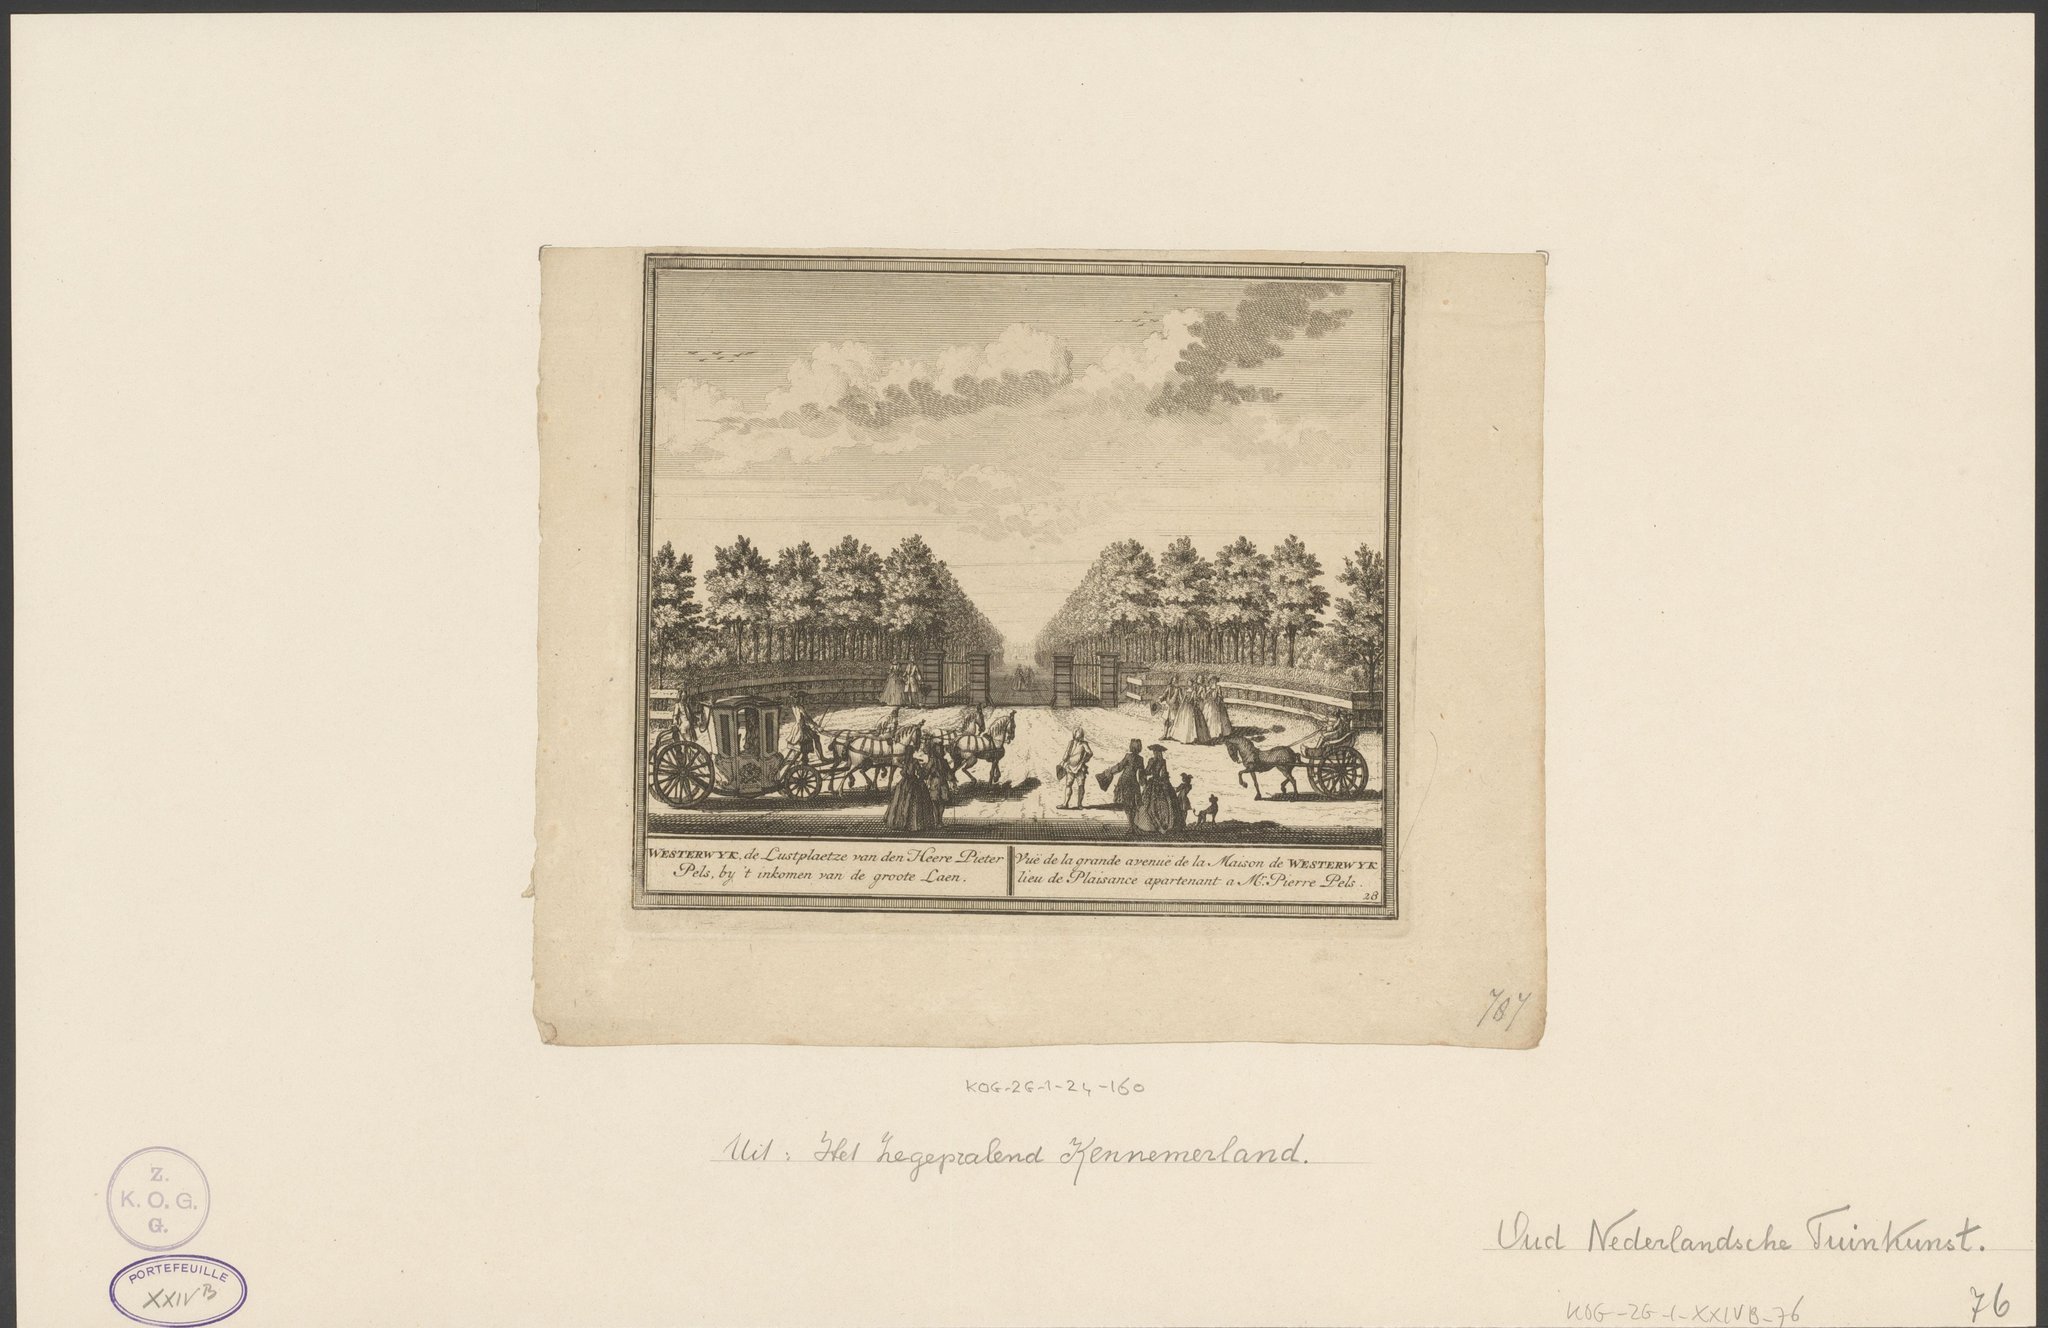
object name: print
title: Westerwyk, de Lustplaetze van den Heere Pieter Pels, bij 't inkomen van de groote Laen / Vuë de la grande avenuë de la Maison de Westerwyk lieu de Plaisance apartenant a Mr. Pierre Pels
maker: hendrik de leth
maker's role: draughtsman, print maker, publisher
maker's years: 1703-1766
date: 1729-1732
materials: paper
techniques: engraving, etching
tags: french or architectonic garden; formal garden, garden pond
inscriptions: stamp, stamp, collector's mark: Lugt 1641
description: Het voorplein en de toegangspoort van het huis Westerwijk tussen Heemskerk en Velsen. Op het plein met koets met vier paarden en wandelaars. Rechtsonder genummerd: 28. Onderwerpsrubrieken binnen de Atlas Zeden en Gewoonten: Zeden en Gewoonten in Engeren Zin, De Woning, Oude Nederlandsche Tuinkunst. De 18de eeuw. Tuinen in Kennemerland, le Nôtre stijl.